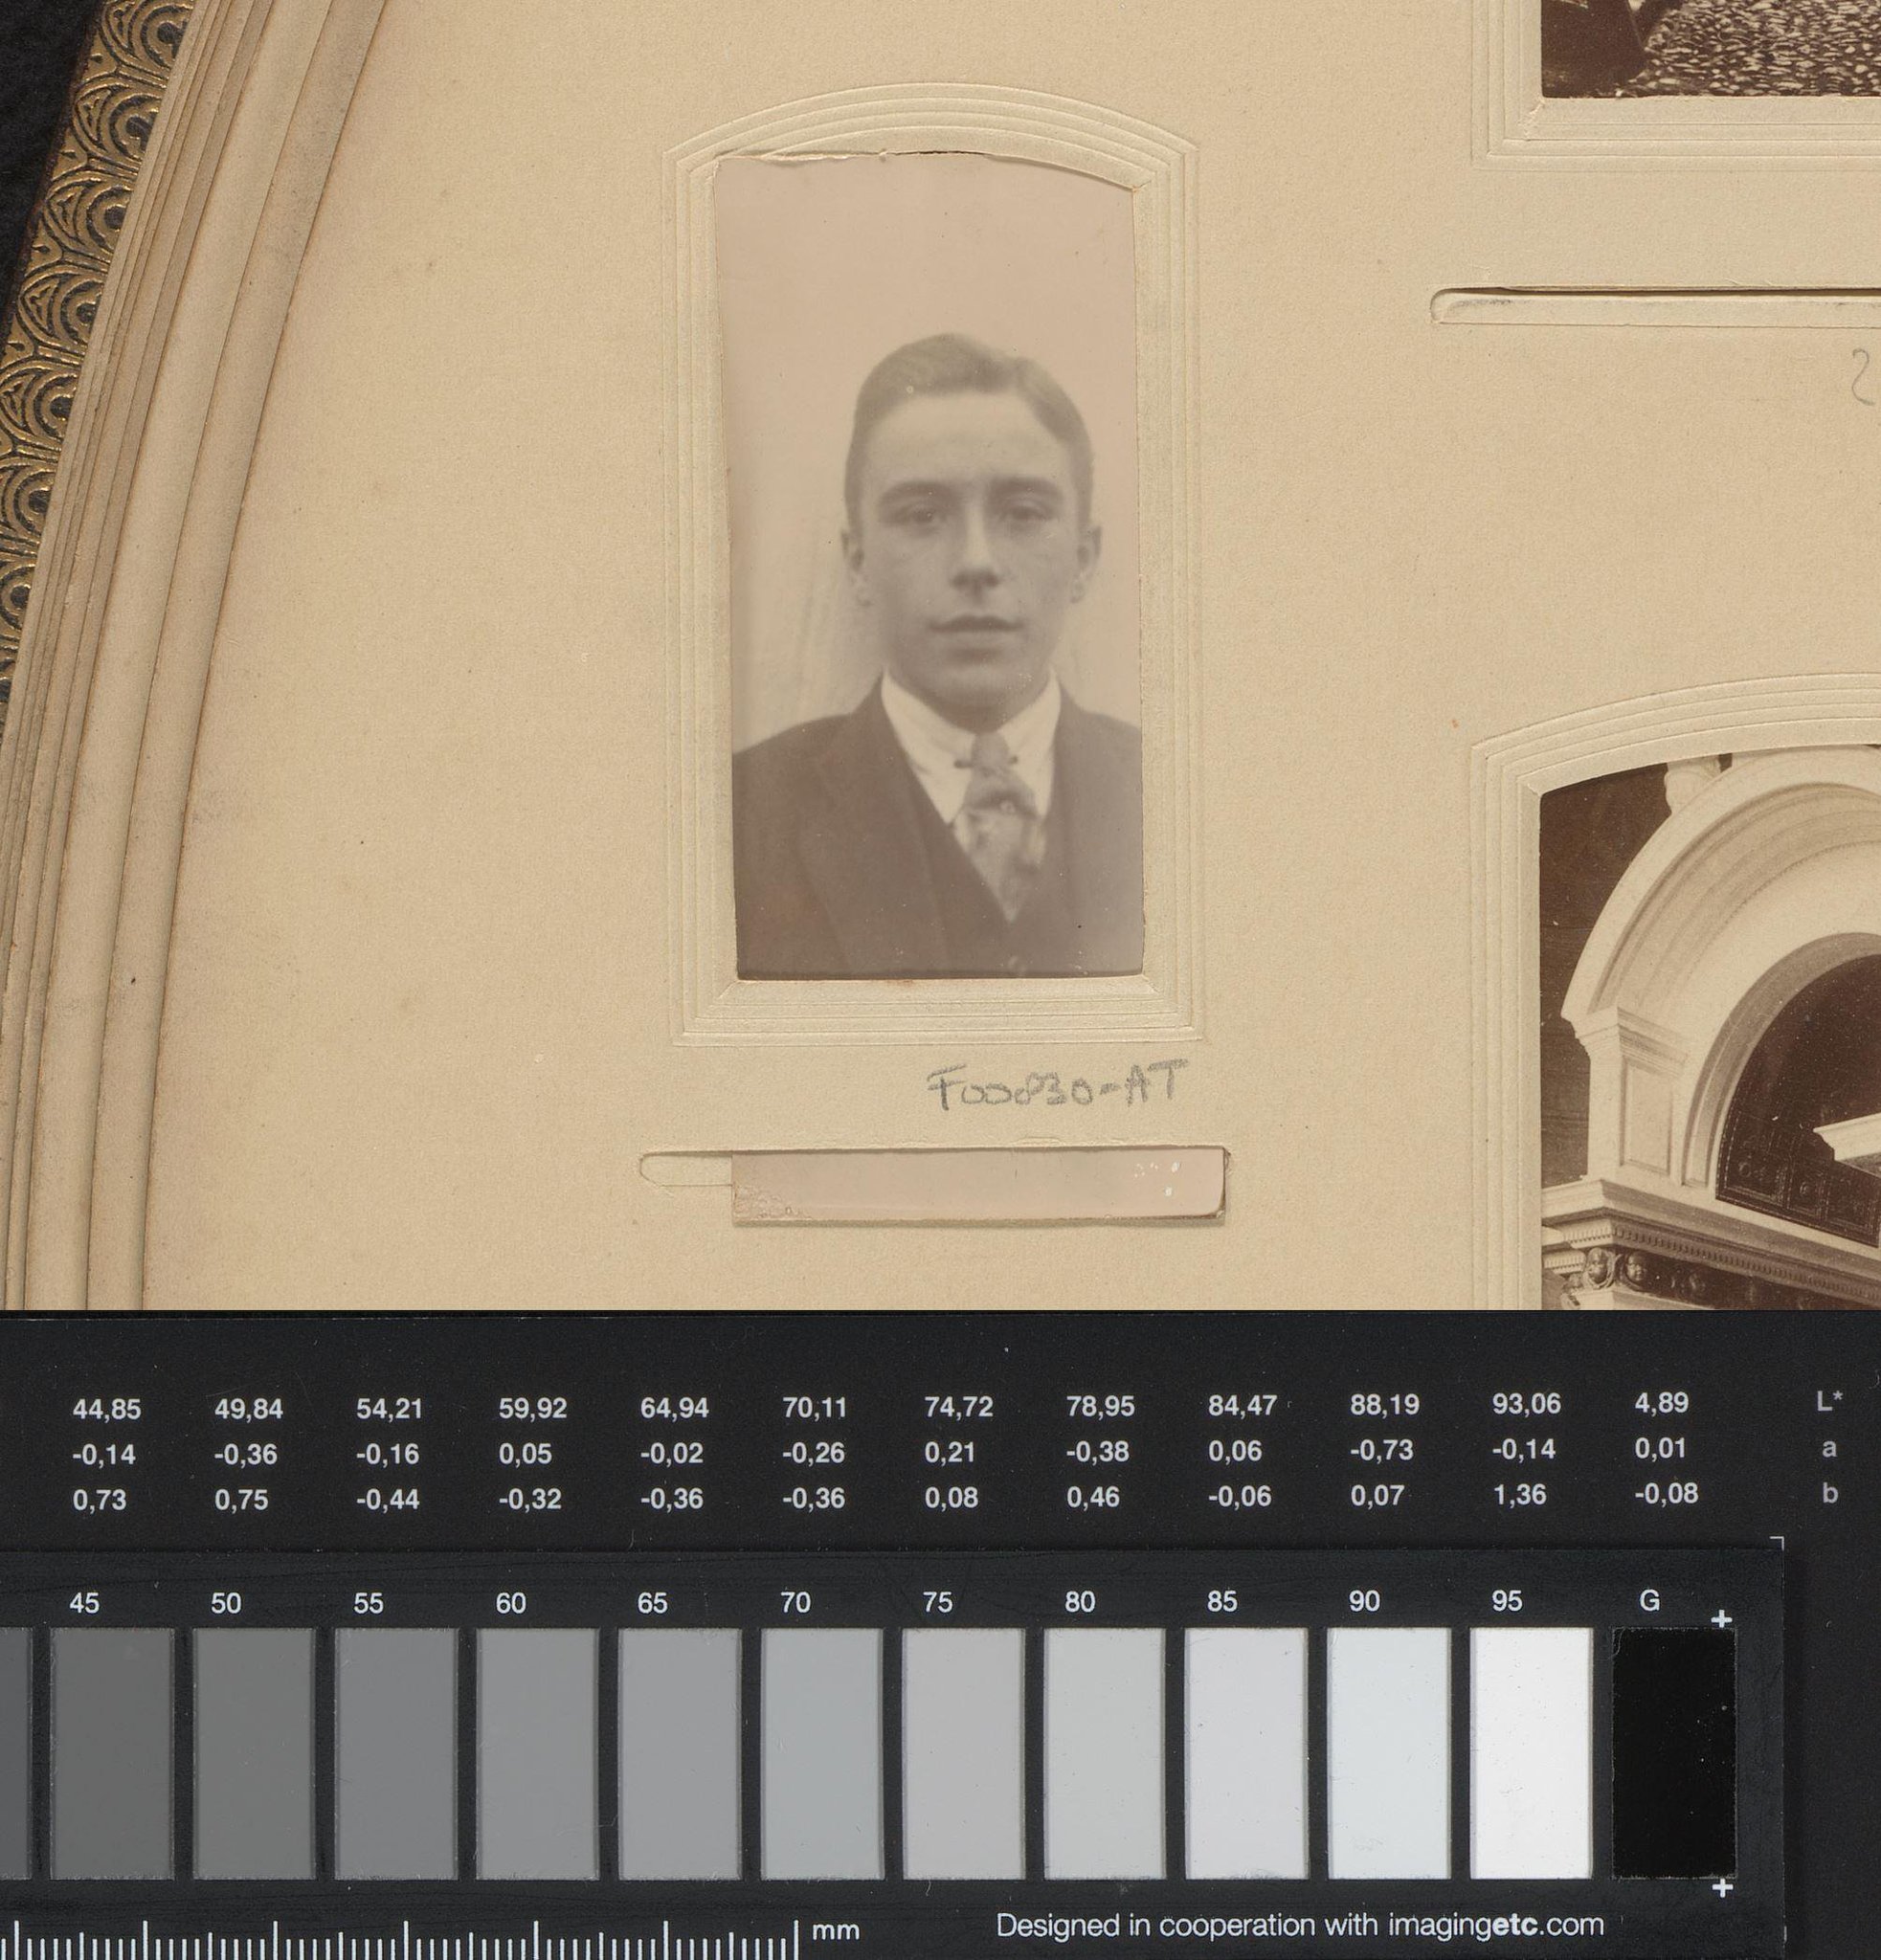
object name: photograph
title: Portret van een jongeman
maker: Anonymous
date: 1890-1910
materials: cardboard, photographic support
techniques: collodion silver print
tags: historical persons, youth, adolescent